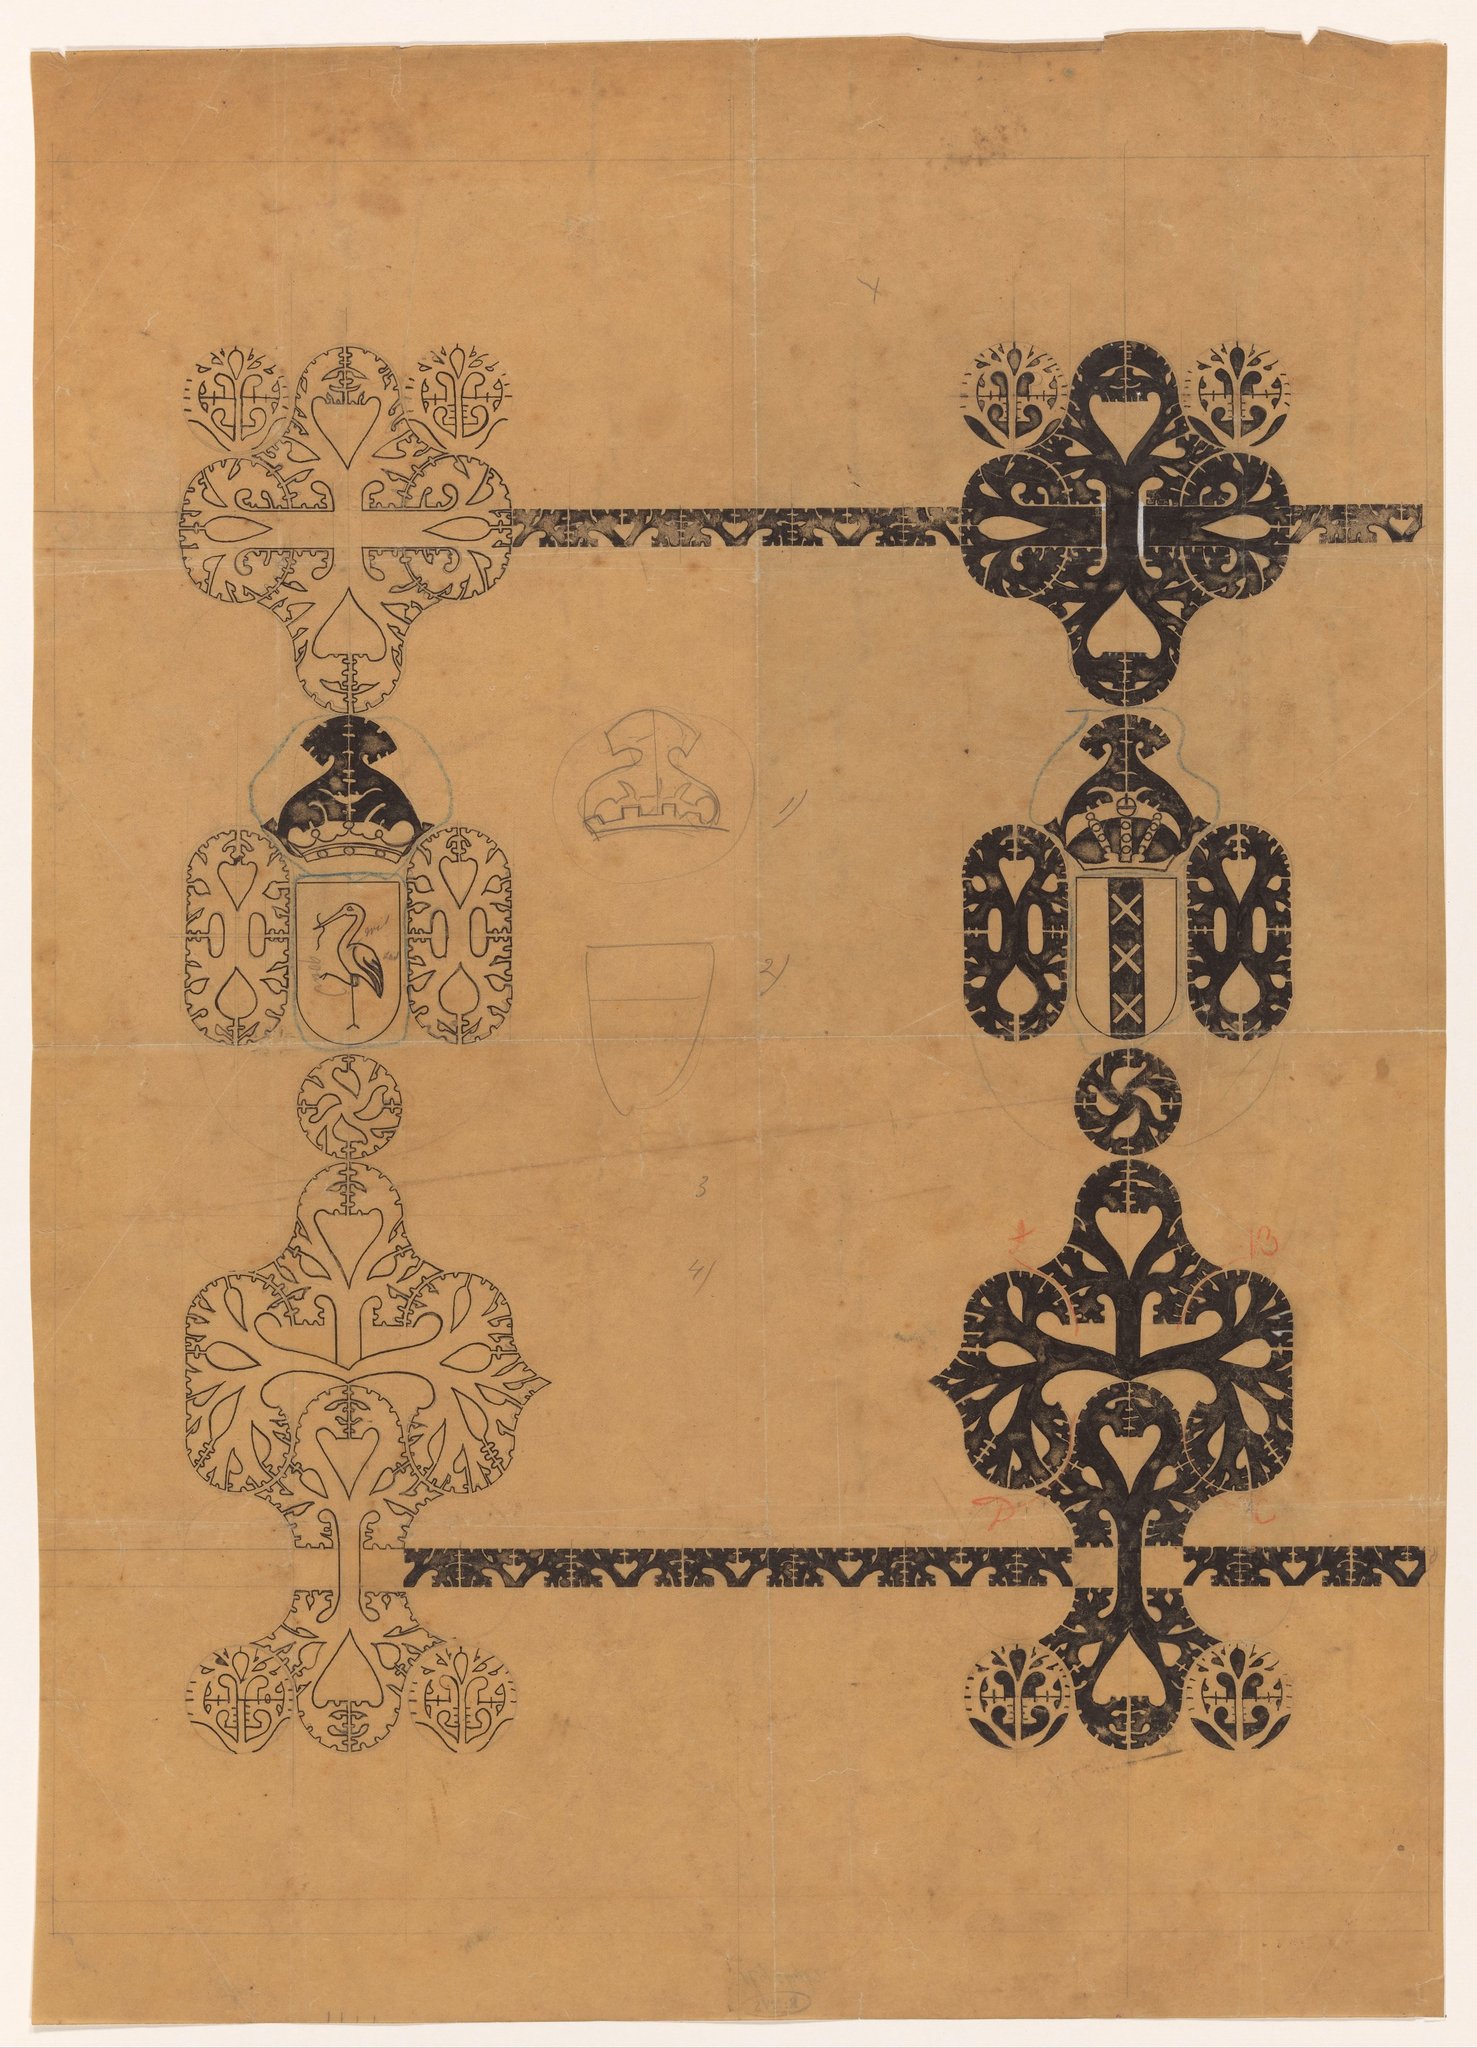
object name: design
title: Ontwerp voor een boekband met het wapen van Den Haag en Amsterdam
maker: carel adolph lion cachet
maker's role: draughtsman, print maker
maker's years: 1864-1945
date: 1874-1945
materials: ink, pencil, paper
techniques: brush, pen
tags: ornaments ~ art, book-cover, binding